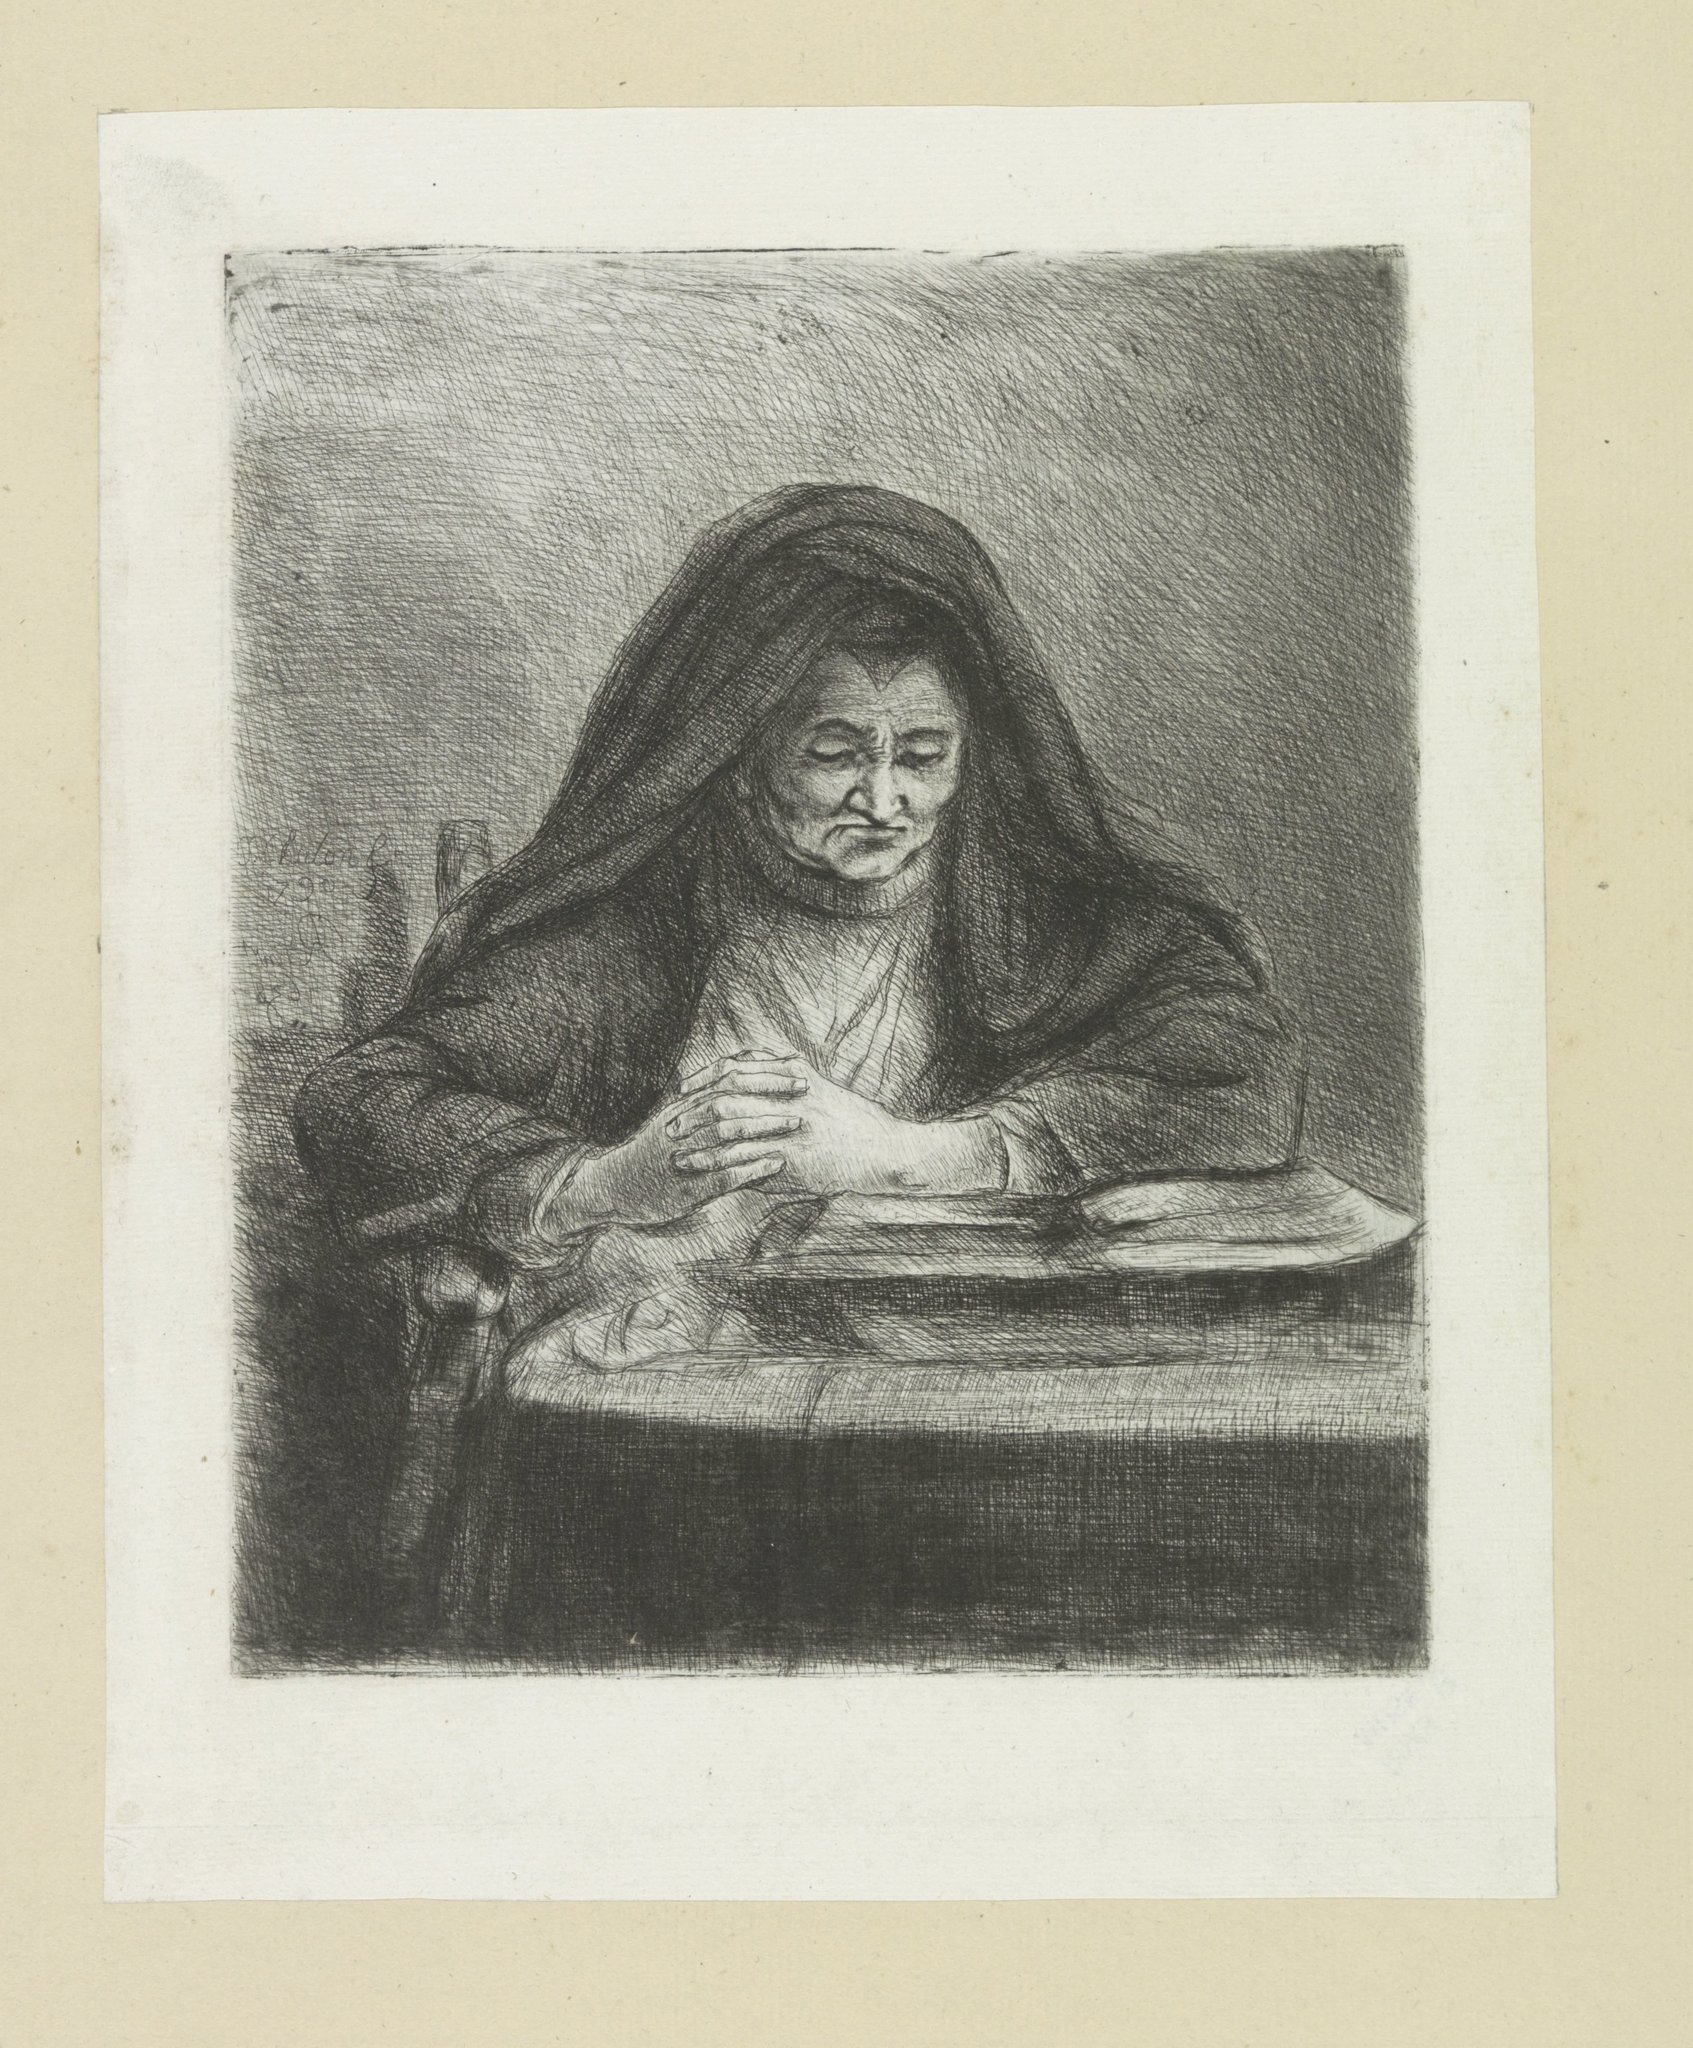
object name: album leaf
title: Lezende vrouw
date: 1790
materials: paper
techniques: drypoint, etching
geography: london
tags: reading, head-gear, morphology of human expression (+ old female (human being))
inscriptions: collector's mark: ‘RIJKS / MUSM’, collector's mark: ‘B’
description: Een oude vrouw met zwarte sluier. Ze zit op een stoel aan een tafel en leest uit een boek. Haar handen gevouwen. De prent maakt deel uit van een album.